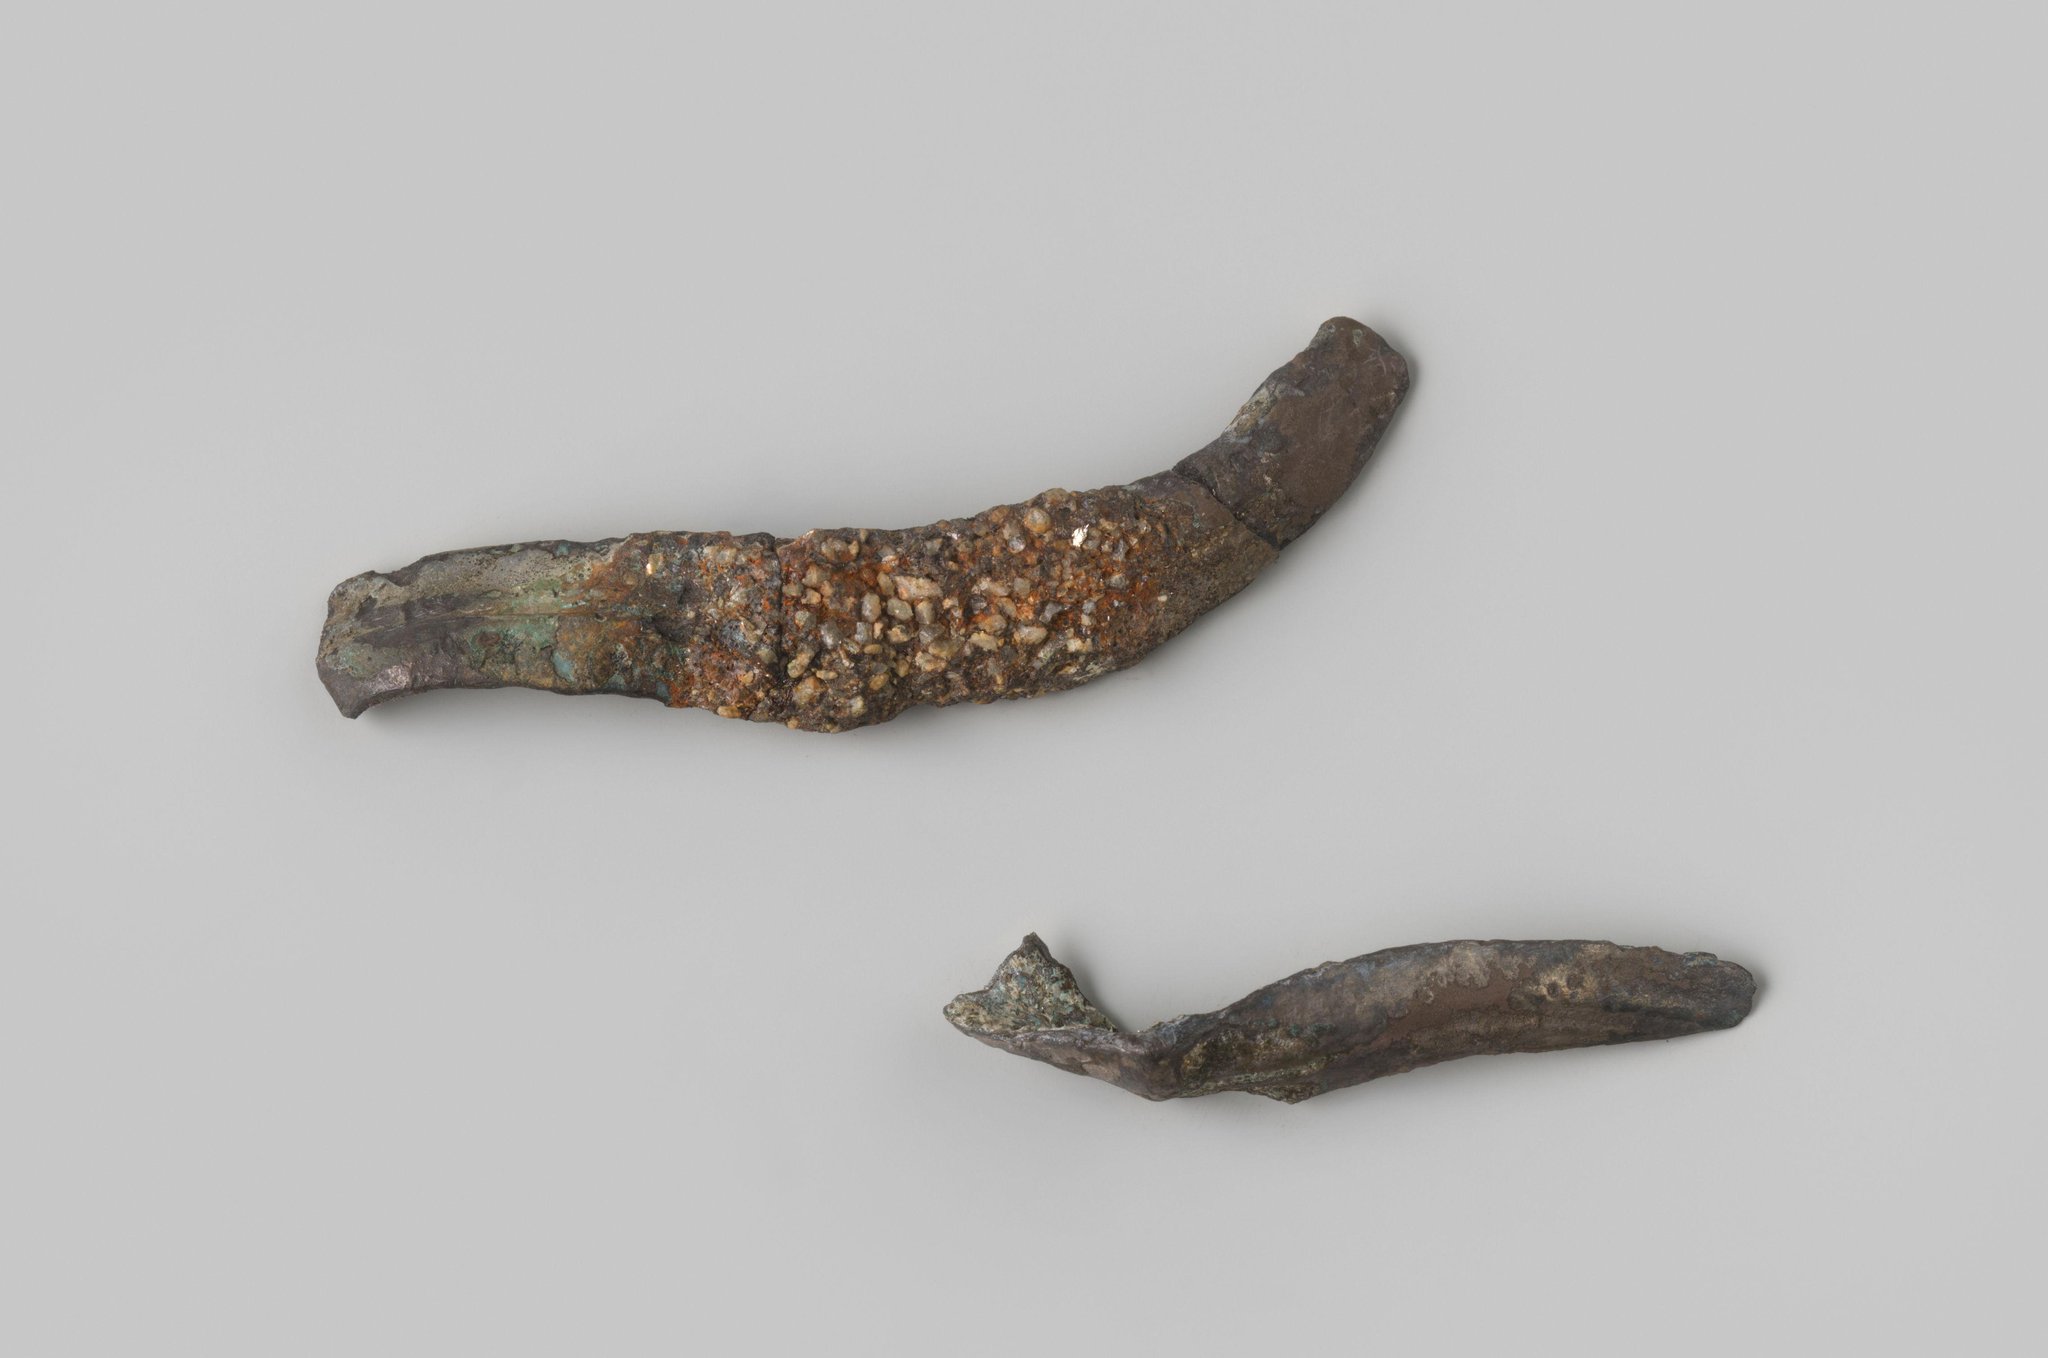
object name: candlestick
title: Fragmenten voet van een kandelaar uit het wrak van de Oost-Indiëvaarder Hollandia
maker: Anonymous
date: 1700-1743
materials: silver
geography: netherlands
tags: verenigde oostindische compagnie, hollandia (schip), annet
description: Candlestick, foot; fragm of moulded rims, sim. NG-1980-27H2812.